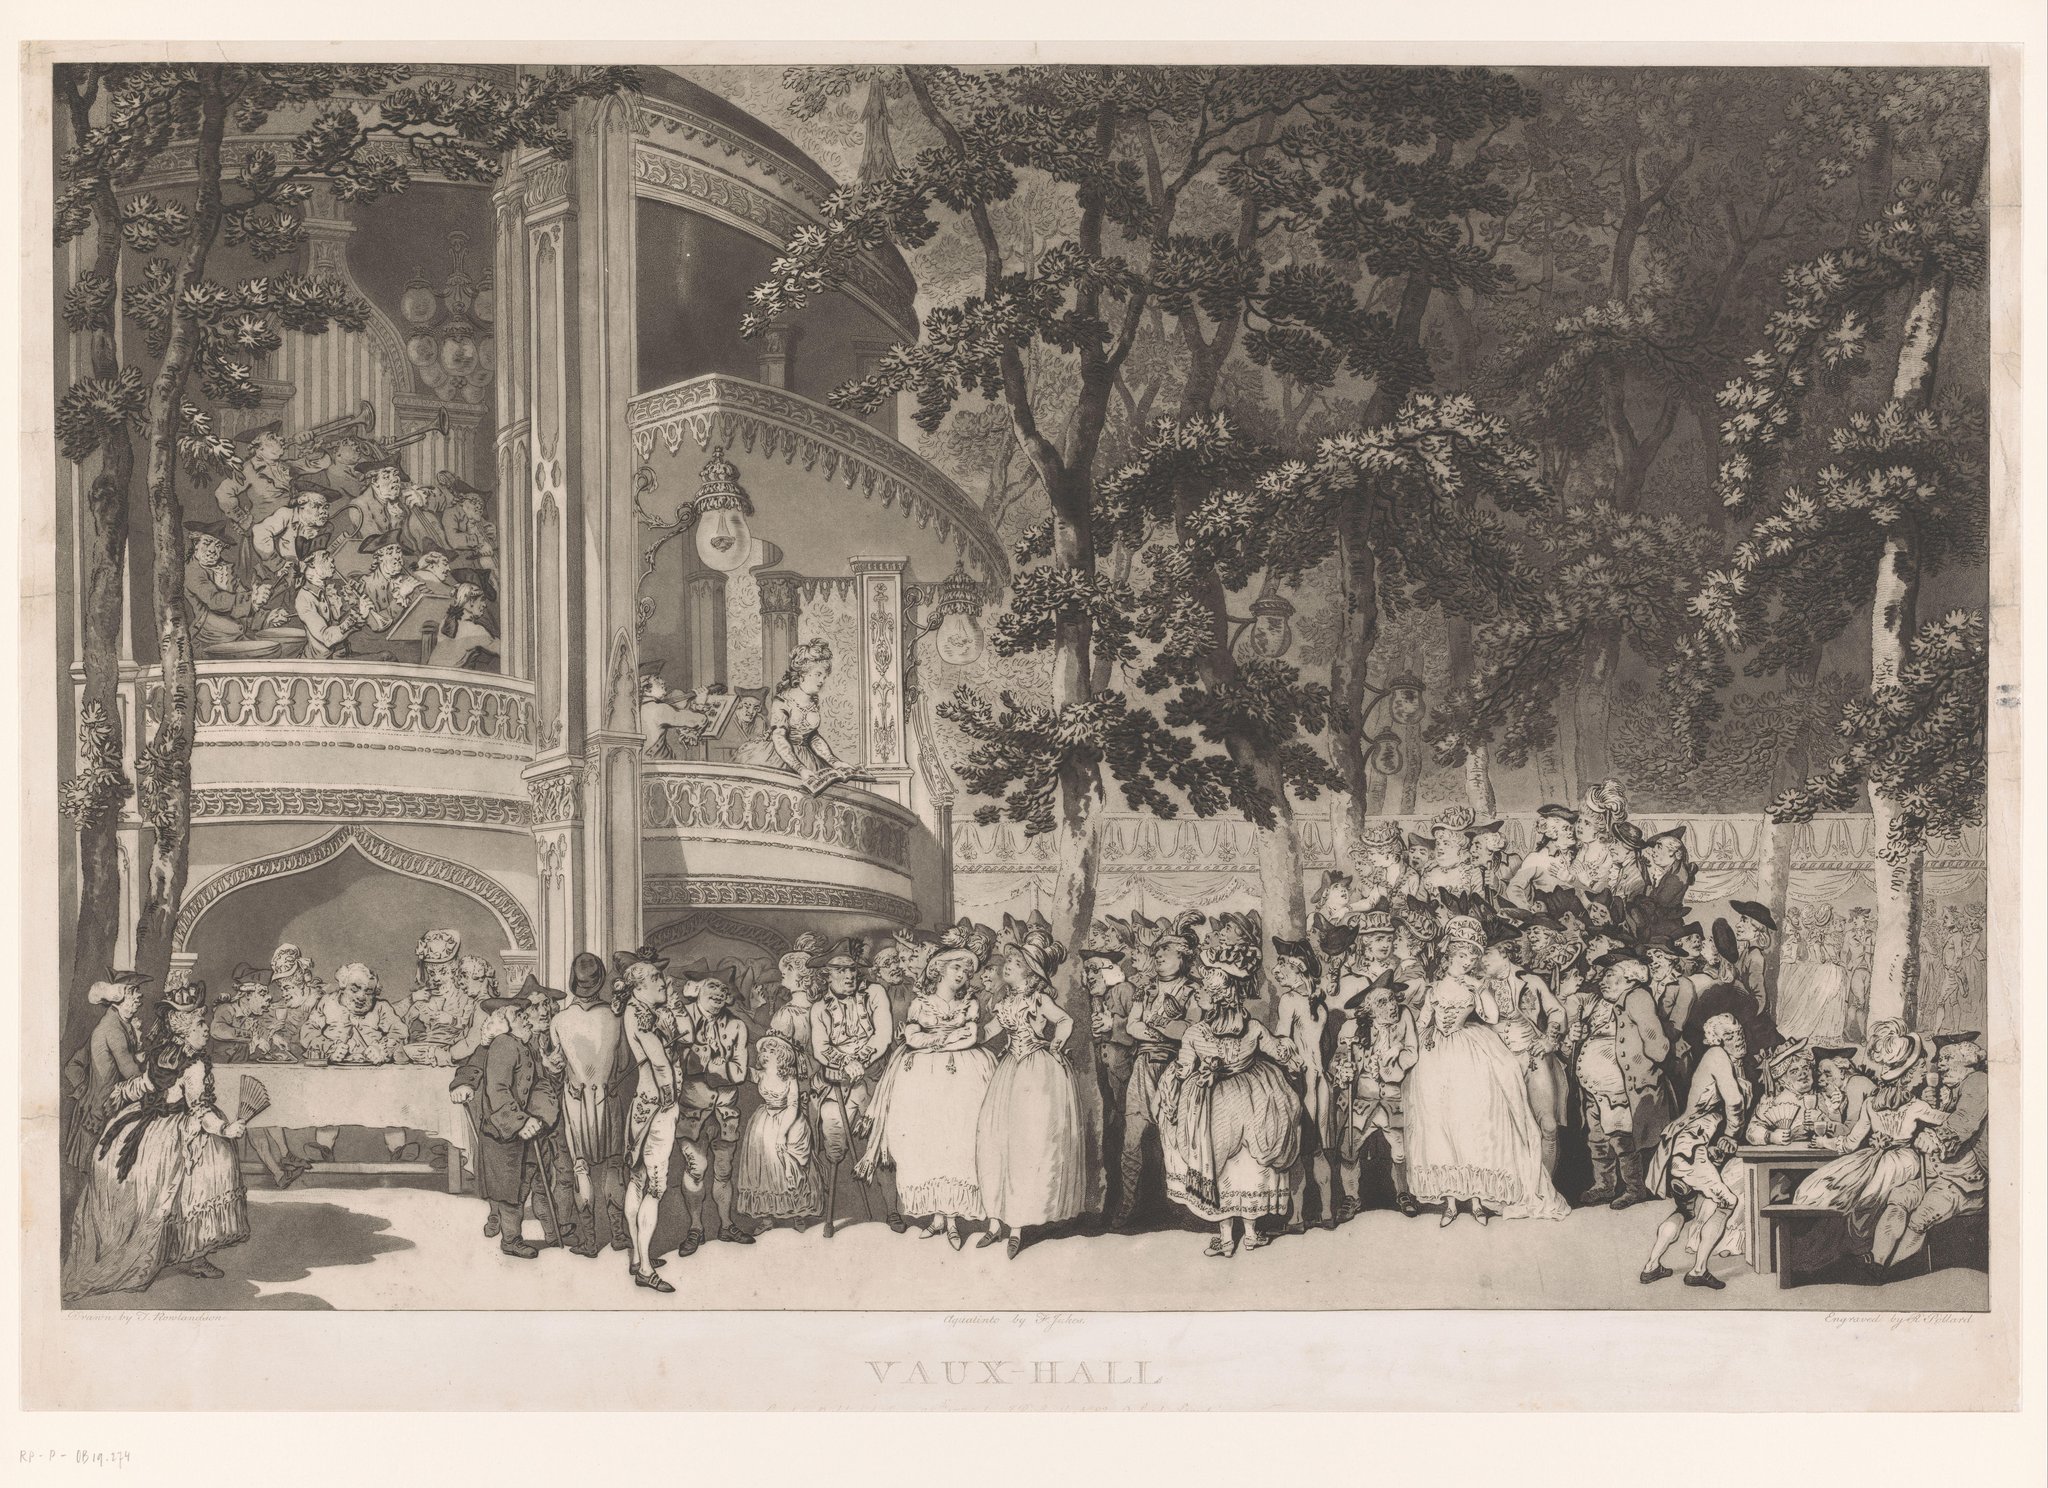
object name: print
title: Vaux-Hall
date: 1785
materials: paper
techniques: aquatint, engraving, etching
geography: london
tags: jonathan tyers, musician, henrietta ponsonby (gravin van bessborough), georgiana spencer (hertogin van devonshire), draughtsman, edward topham, london, oliver goldsmith, george iv (koning van het verenigd koninkrijk), pleasure, enjoyment, joy; 'allegrezza', 'allegrezza da le medaglie', 'allegrezza, letitia e giubilo', 'diletto', 'piacere', 'piacere honesto' (ripa), historical persons, opera-singer (female), courting, evening meal, dinner, supper, madam (brothel scene)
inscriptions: collector's mark: ‘School voor de grafische vakken te Utrecht’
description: Een menigte van 'Nobles and Nobodies' in het populaire lusthof Vauxhall Pleasure Gardens in Londen. Enkele personen uit de Londense high society kunnen worden geïdentificeerd. De vocalist op het balkon is de 38-jarige Frederika Weichsel. In het orkest zit Jacob Nelson, de paukenist die vanaf 1753 optrad in Vauxhall Gardens. Naast hem zit John Abraham Fisher op hobo en mogelijk Hezekiah Cantelo. Vooraan bij Weichsel zit de violist François Hippolite Barthélémon, die in 1783 met pensioen ging. James Hook, componist, organist en muzikaal directeur, is mogelijk zichtbaar tussen Barthélémon en de zangers. Rechts op de voorgrond fluistert de prins van Wales (de latere koning George IV) iets in het oor van de actrice Mary Robinson (ook bekend als Perdita Robinson), die gearmd staat met haar kleinere oudere echtgenoot, Thomas Robinson. Om hen heen staan waarschijnlijk leden van de familie Tyers, uitbaters van de Vauxhall Gardens (mogelijk Jonathan en Margaret of Bryant Barrett en zijn vrouw Eliza). De vrouw aan tafel rechts is mevrouw Barrey, een bekende madam werkzaam op Sutton Street, Soho in Londen, met één van haar werkneemsters en gezelschap. Links vooraan staart 'macaroni' Edward Topham, bekend als 'scandalmonger to the world', door zijn monocle naar Giorgiana Spencer, later Cavendish, de hertogin van Devonshire en haar zus Henrietta Frances Spencer, later Ponsonby, burggravin van Duncannon en gravin van Bessborough. Achter een boom staat Henry Bate-Dudley, 'Fighting Parson' redacteur van de Morning Herald, of Thomas Tyers, entrepreneur en uitbater van Vauxhall Gardens tussen 1729 en 1767. Daarnaast staat James Perry. In de loge linksonder, de 'supperbox', zitten de schrijvers Samuel Johnson, James Boswell, Oliver Goldsmith en Hester Lynch Piozzi , ook bekend als Hester Thrale.